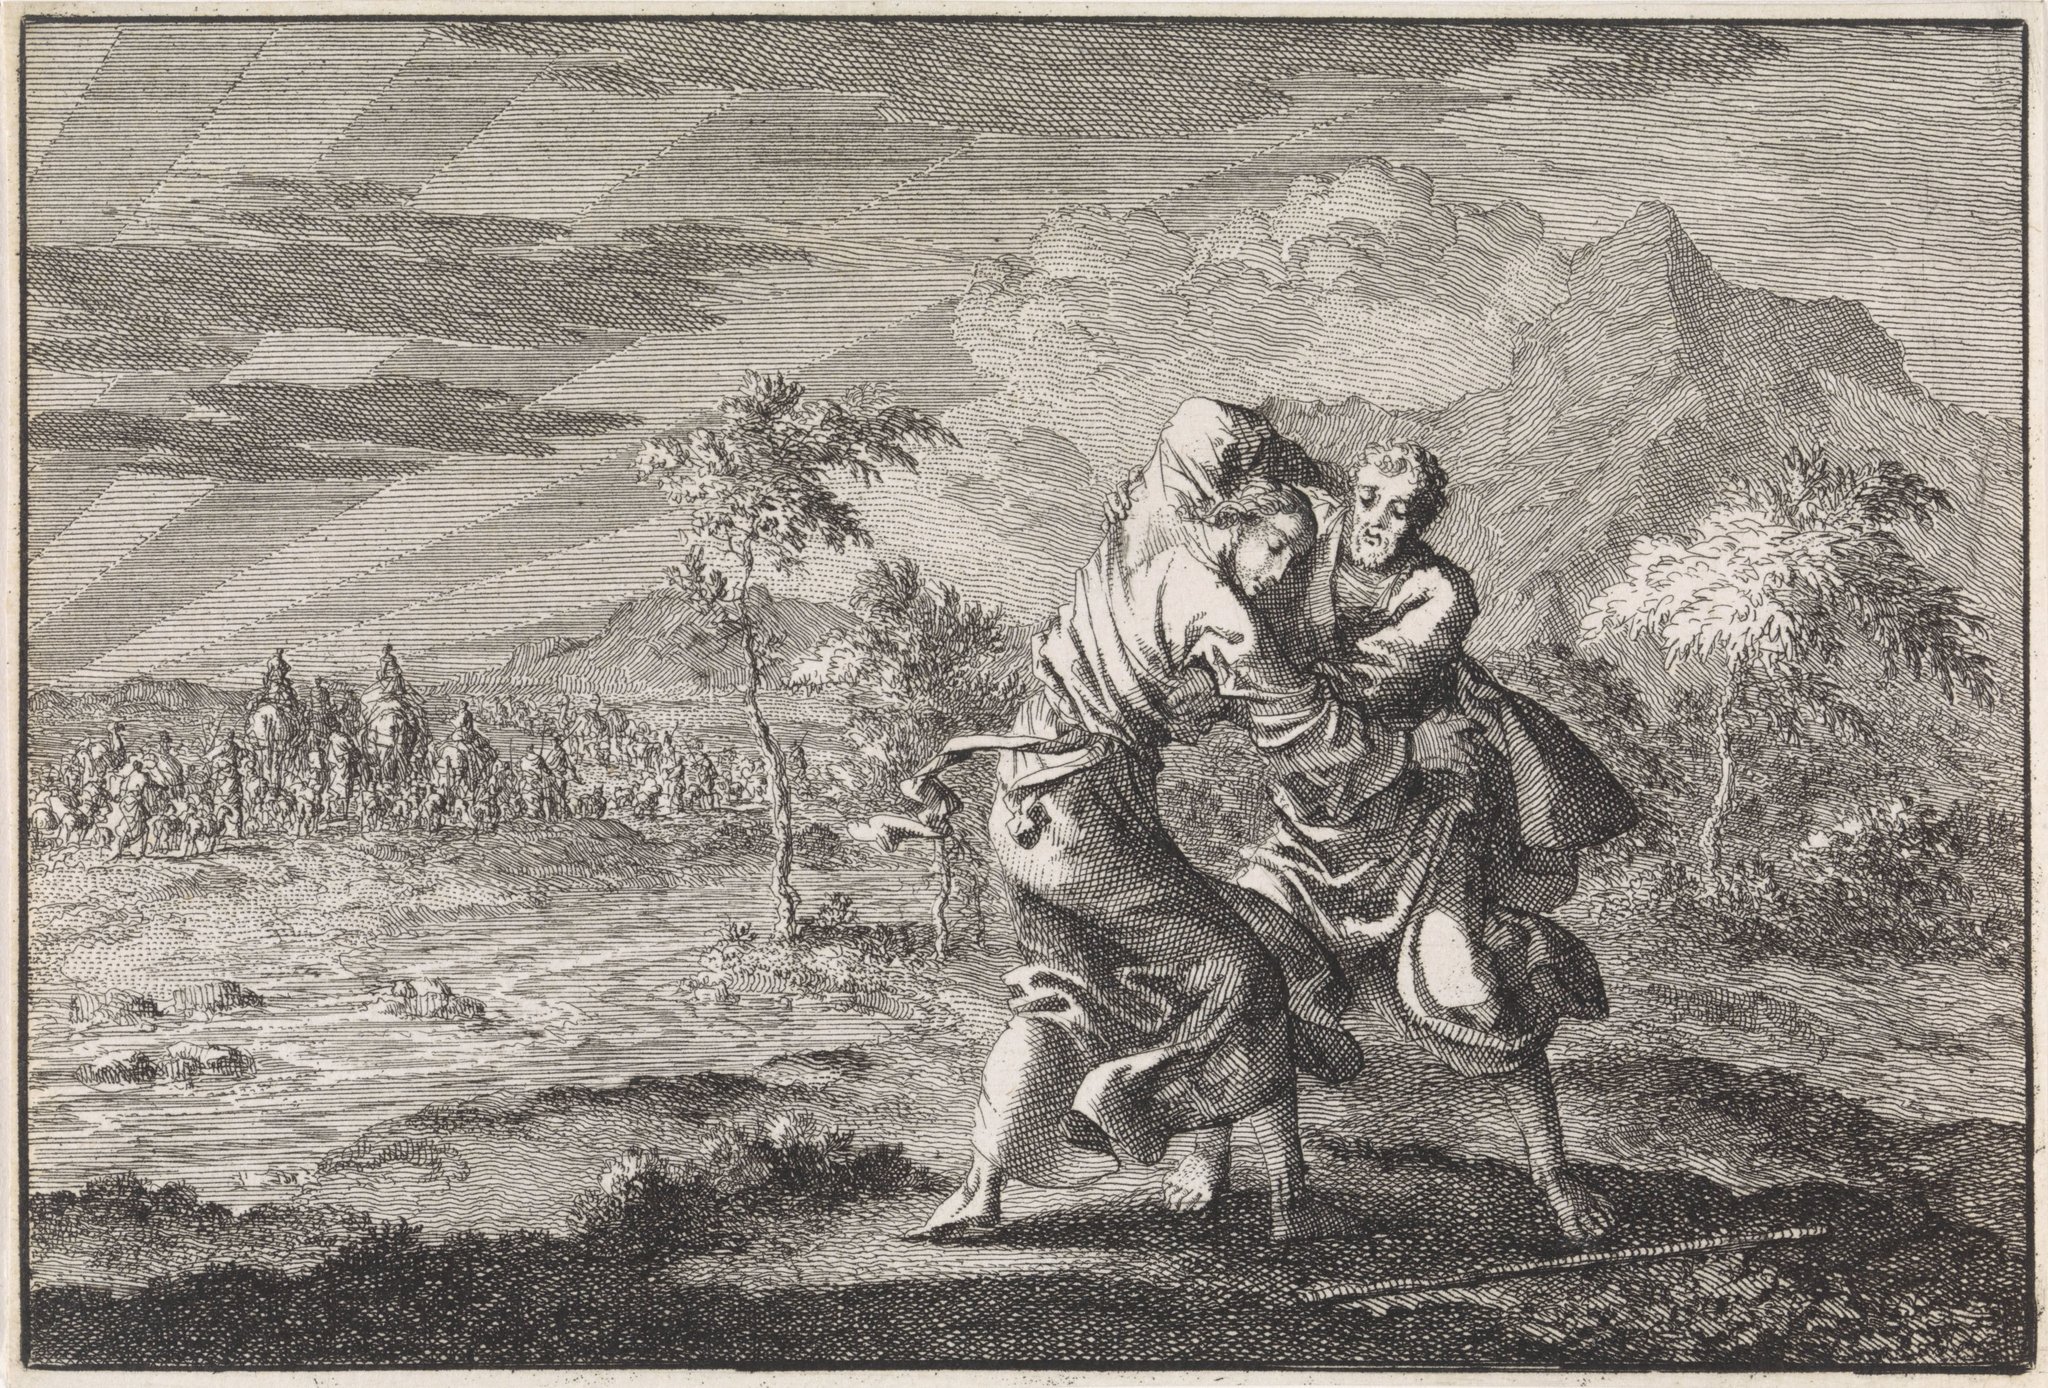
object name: print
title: Jakob in gevecht met de engel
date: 1703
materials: paper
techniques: etching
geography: amsterdam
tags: jacob wrestles with the angel (or man) till daybreak; jacob's thigh is put out of joint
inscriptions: number: ‘10’, collector's mark: Lugt 2228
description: Proefdruk van een boekillustratie voor David Martin. Historie des Ouden en Nieuwen Testaments. Amsterdam, Pieter Mortier, 1703. Deel I. De boekillustraties voor de Mortierbijbel hebben verschillende staten en kopieën, waarbij de chronologische volgorde moeilijk te achterhalen valt. Als boekillustraties werden ze bovendien herhaaldelijk opnieuw gebruikt voor andere boekwerken.